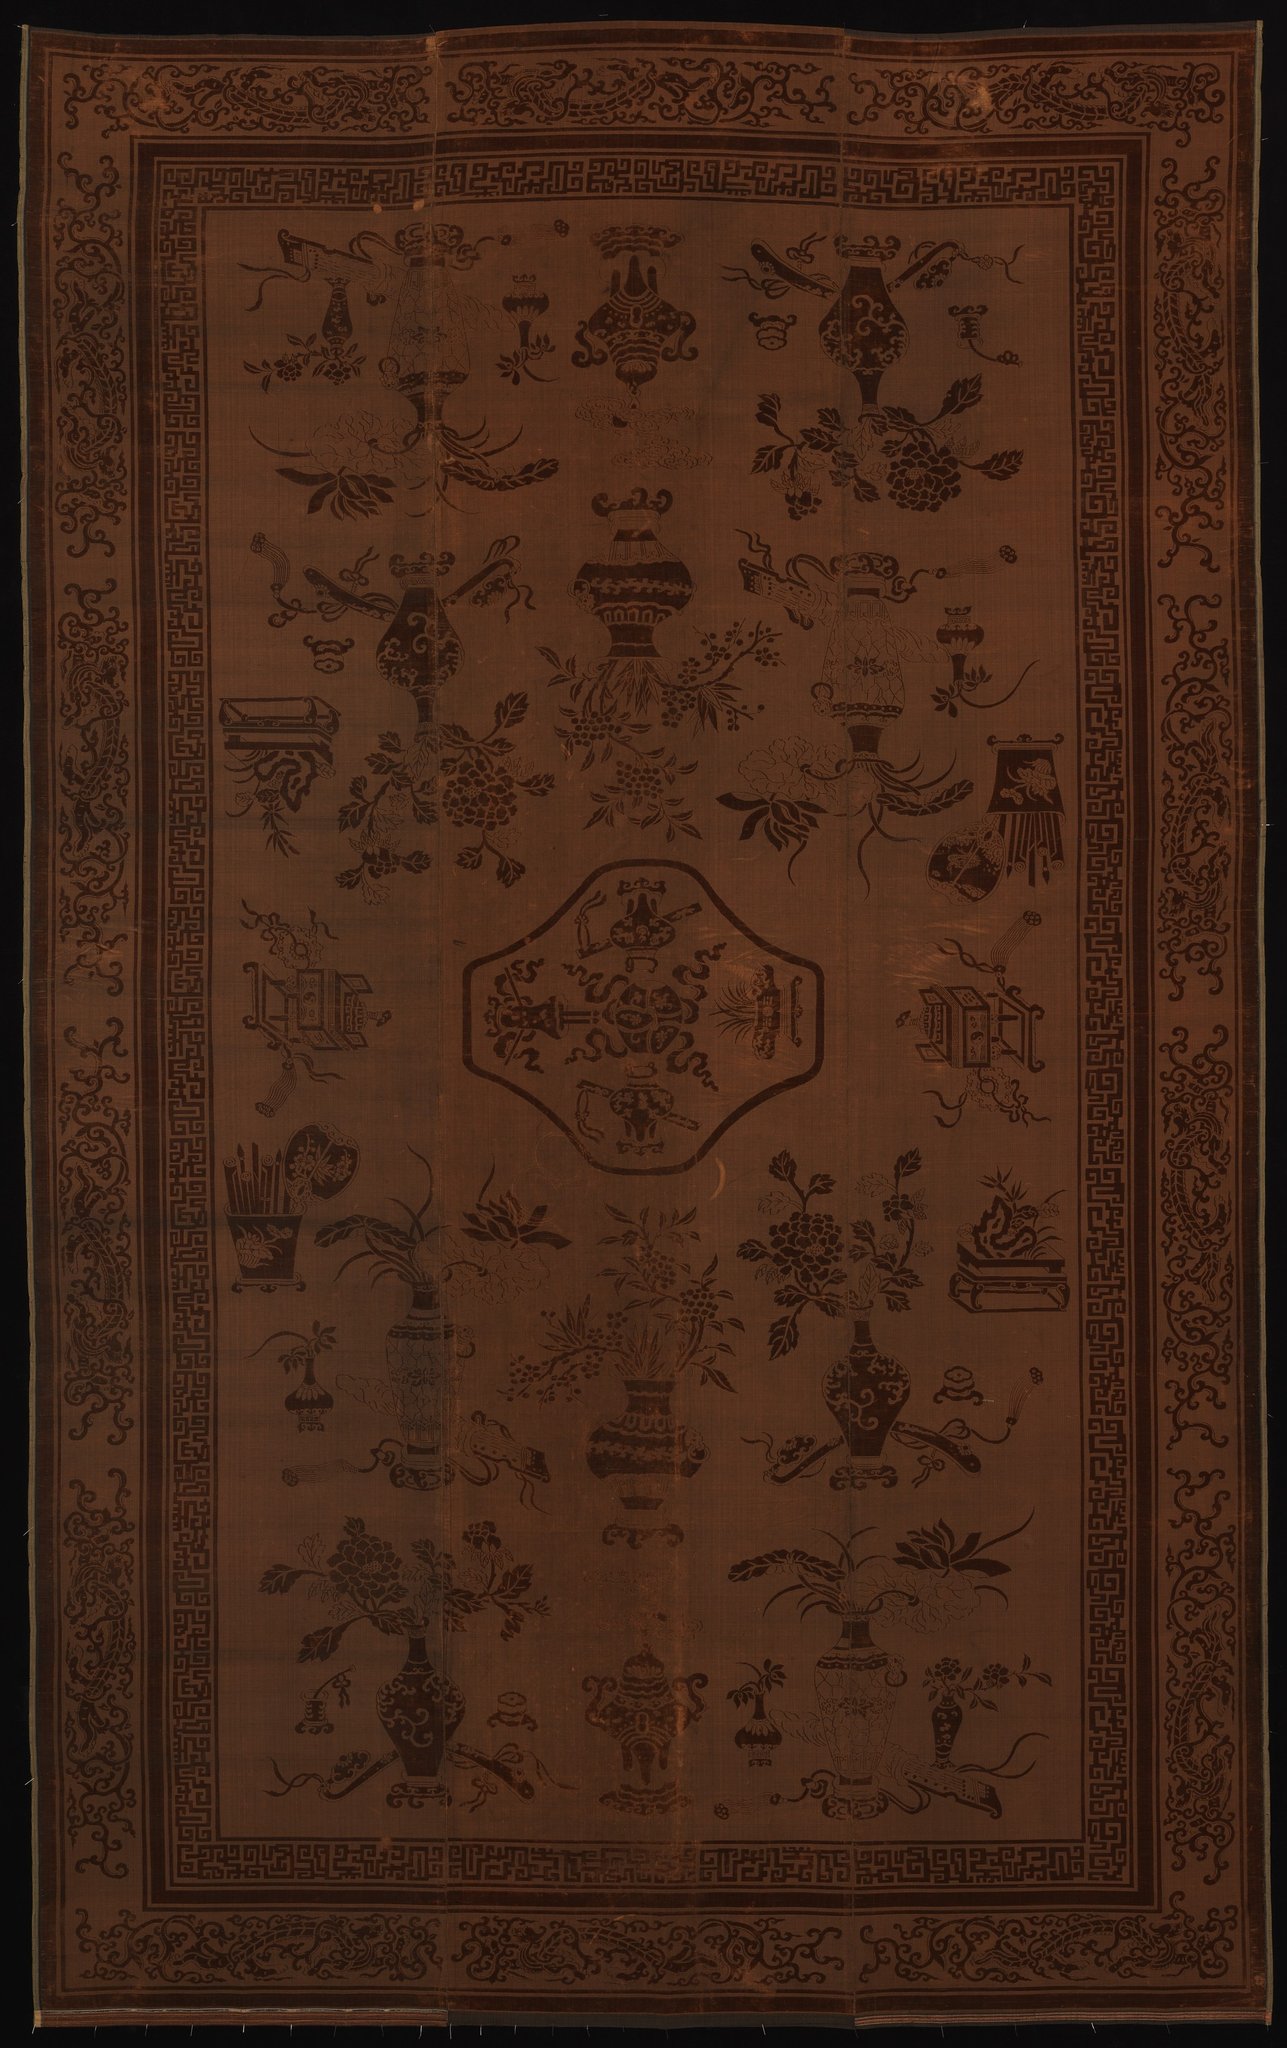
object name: floor covering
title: Floor Covering with Theme of the "Hundred Antiques"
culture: chinese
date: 1801-1900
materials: metal thread, silk